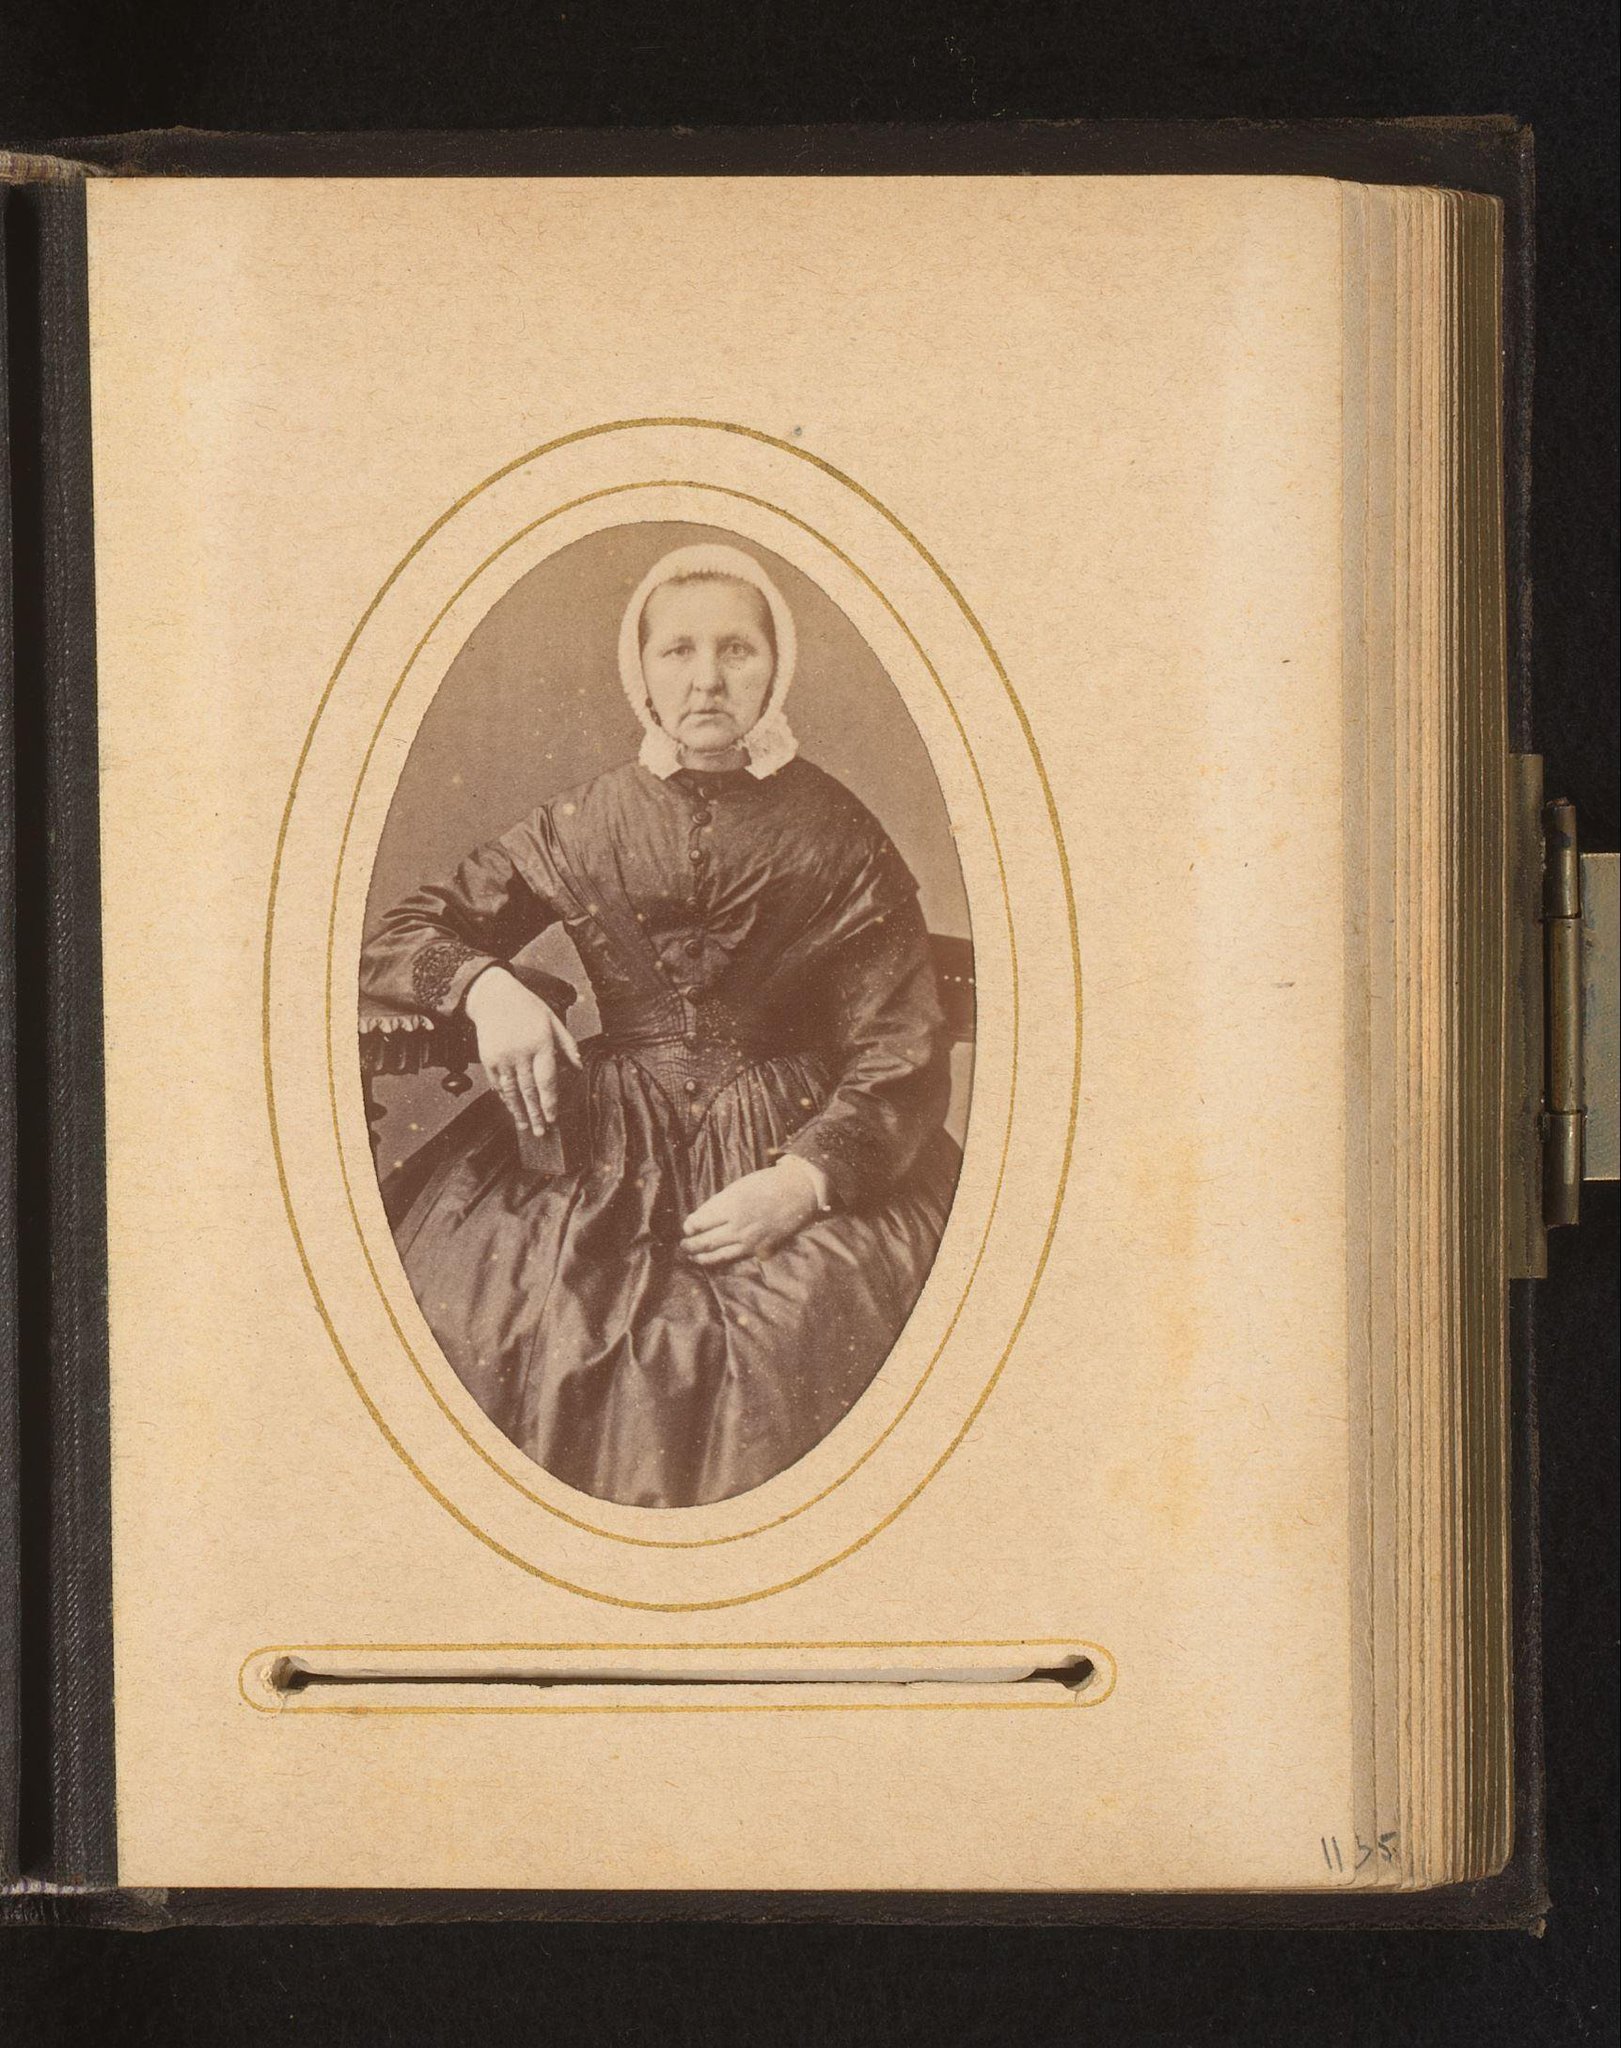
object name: photograph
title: Portret van een zittende vrouw met muts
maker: bernardus bruining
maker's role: fotograaf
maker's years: 1834-1900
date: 1860-1880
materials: cardboard, photographic support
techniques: albumen print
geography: leiden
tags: historical persons - bb - woman, head-gear: cap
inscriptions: inscription: ‘B. Bruining/ Photographe/ van Z.K.H. prins Frederik der Nederlanden te Leiden’